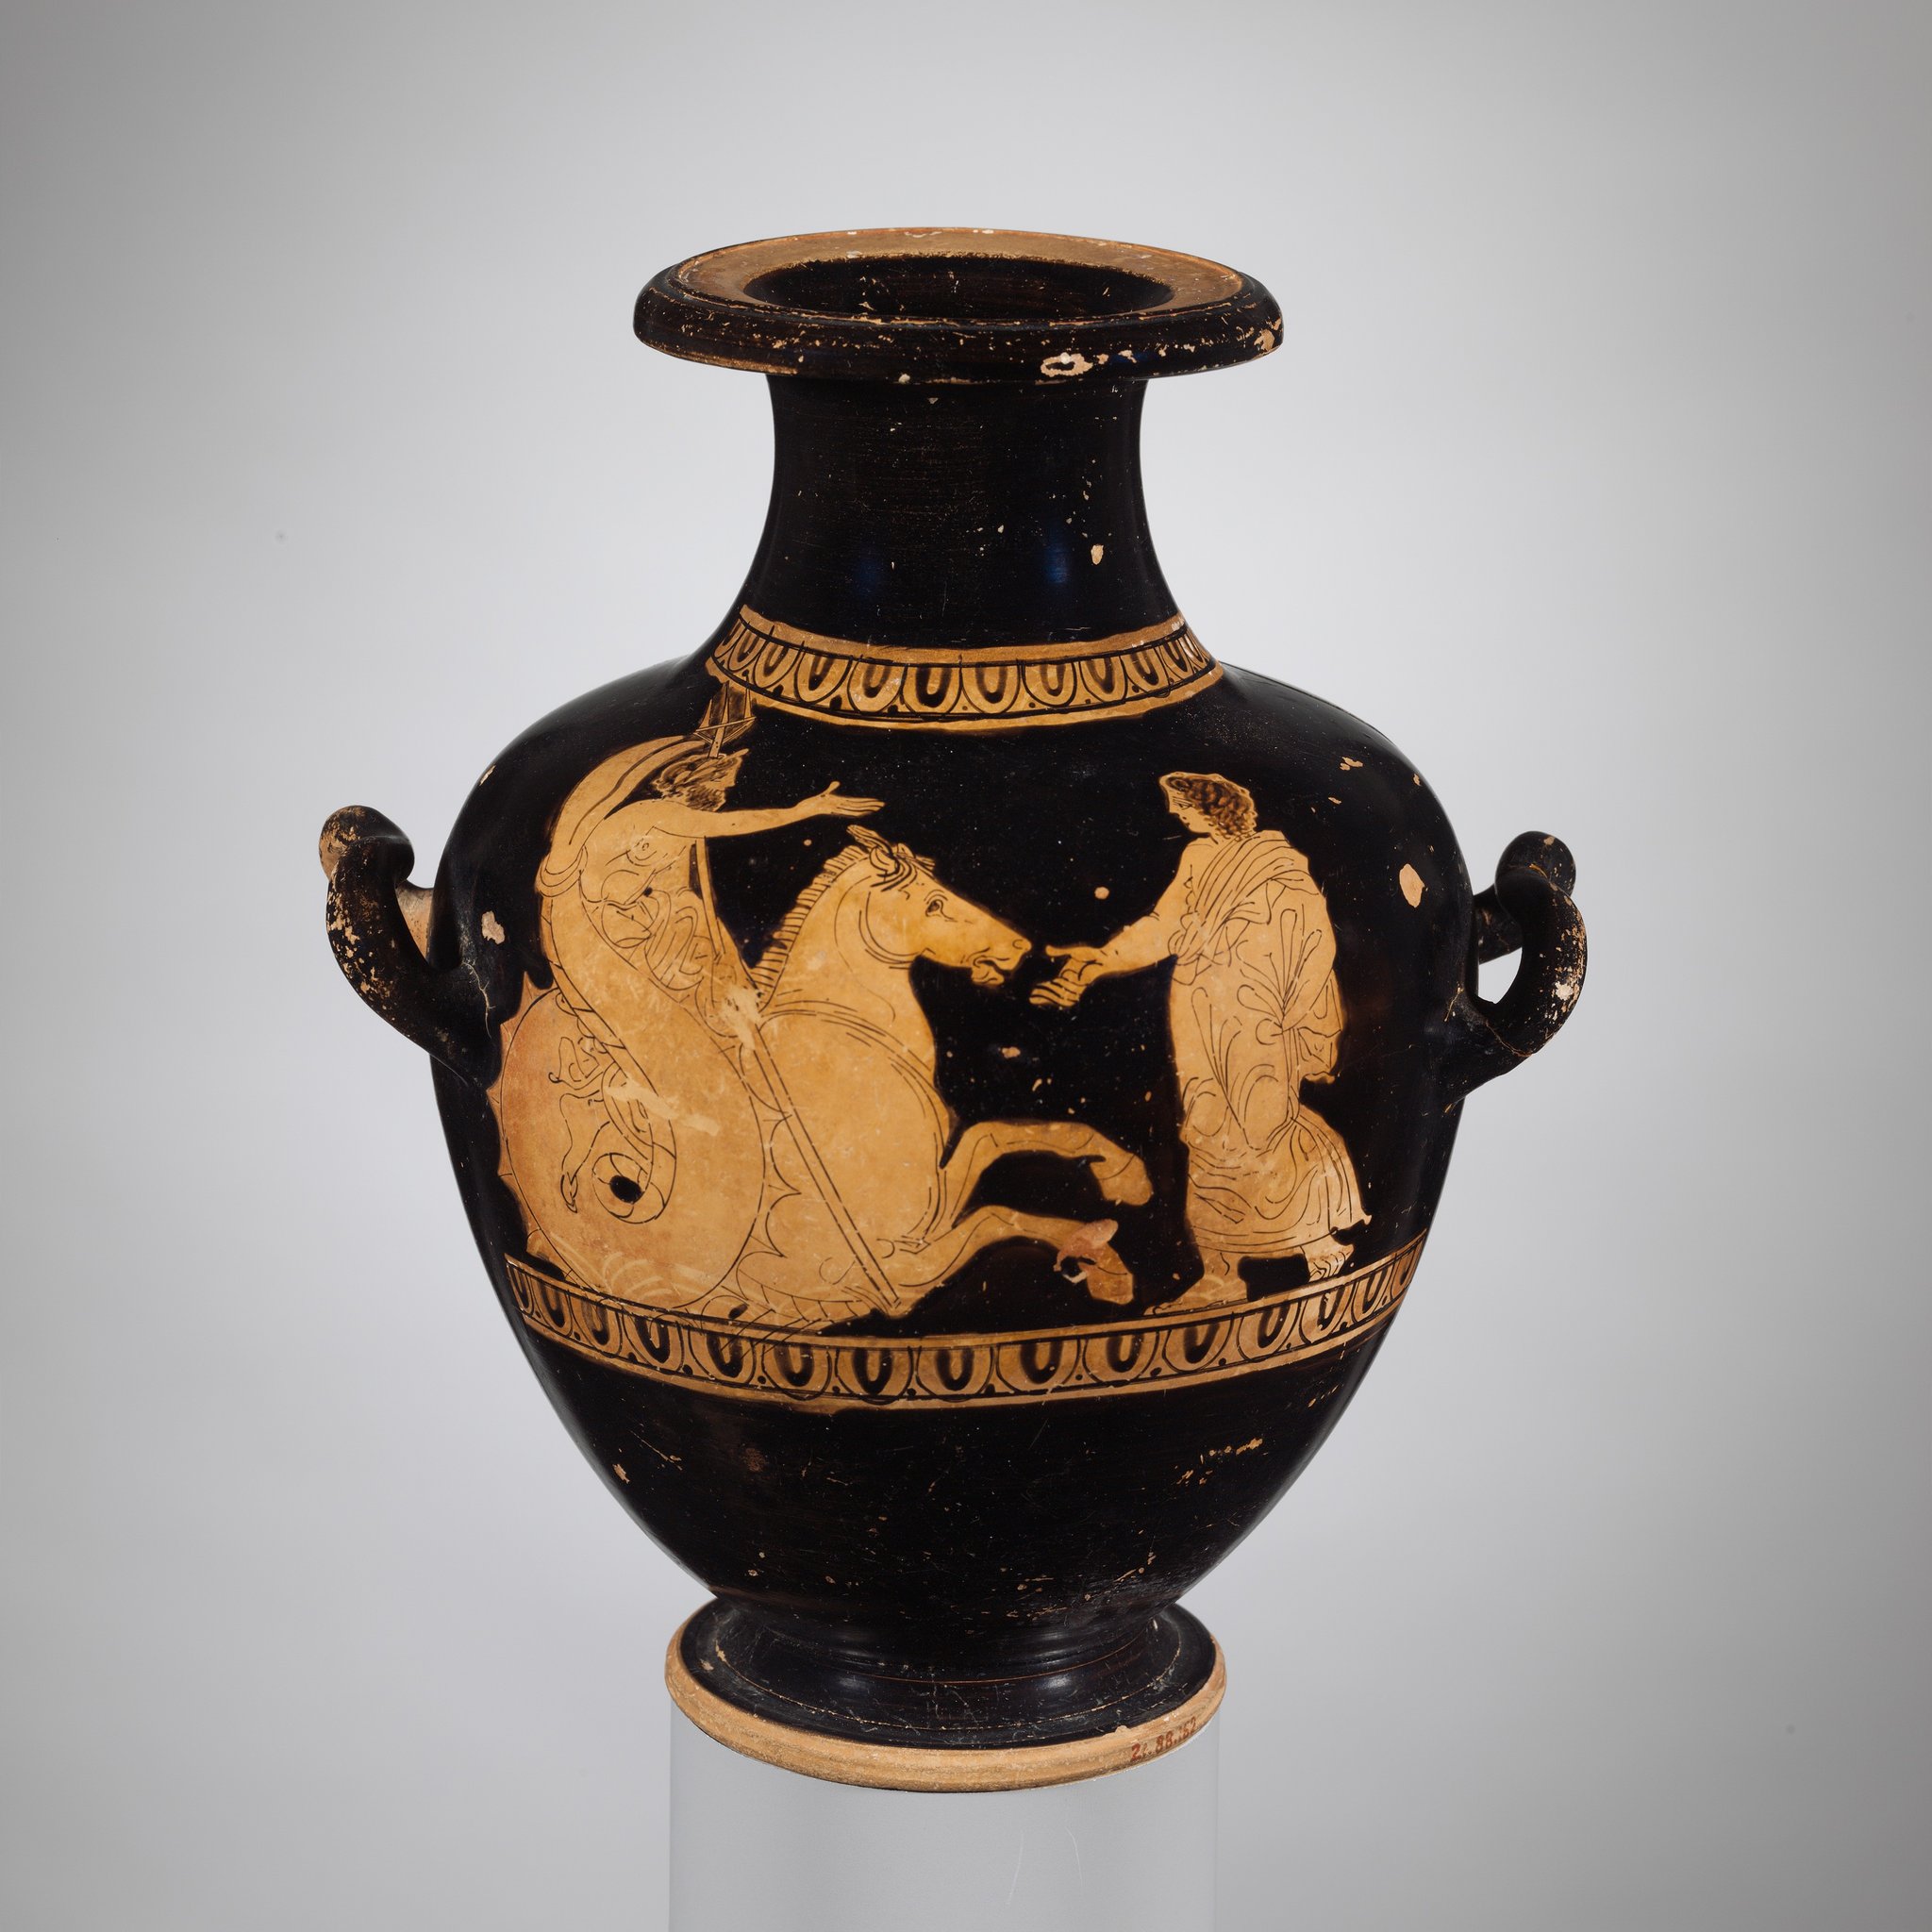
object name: hydria, kalpis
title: Terracotta hydria: kalpis (water jar)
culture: greek, attic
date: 400-376 BCE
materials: terracotta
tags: men,poseidon,seahorses